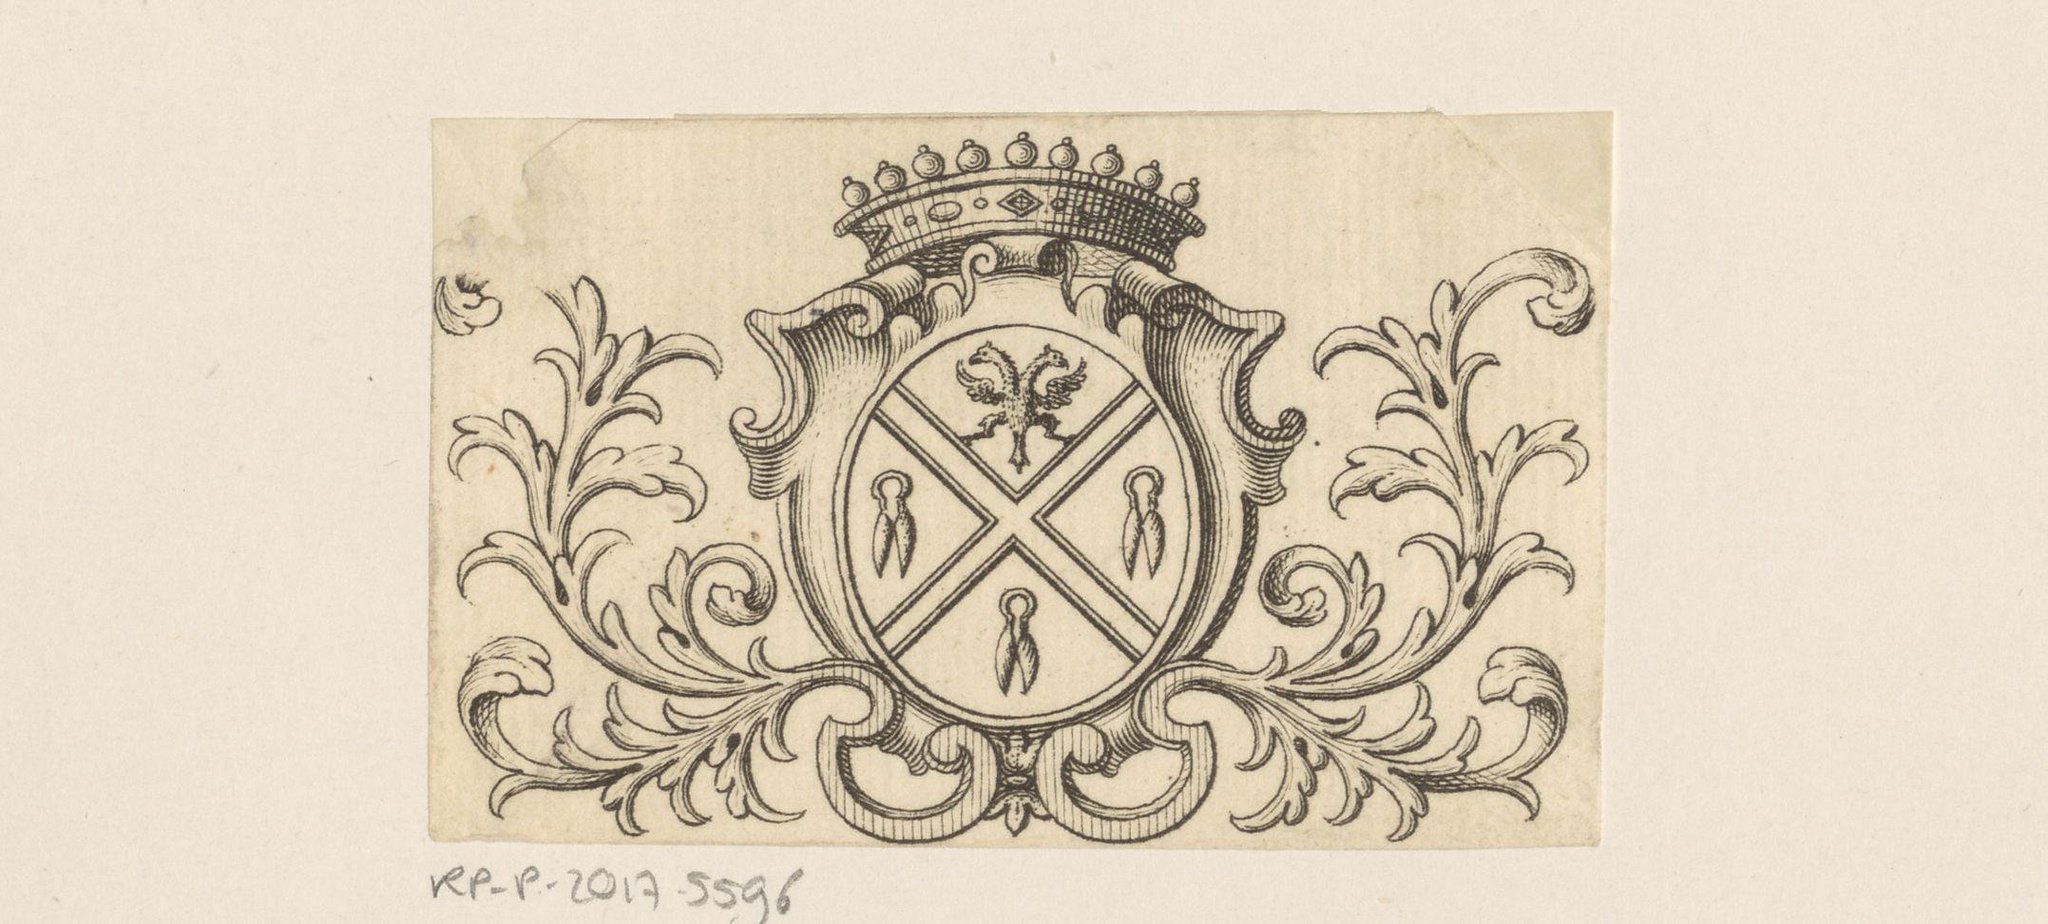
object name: bookplate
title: Ex libris van onbekend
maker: Anonymous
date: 1750-1849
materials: paper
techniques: etching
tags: tools, aids, implements ~ crafts and industries: tongs, armorial bearing, heraldry